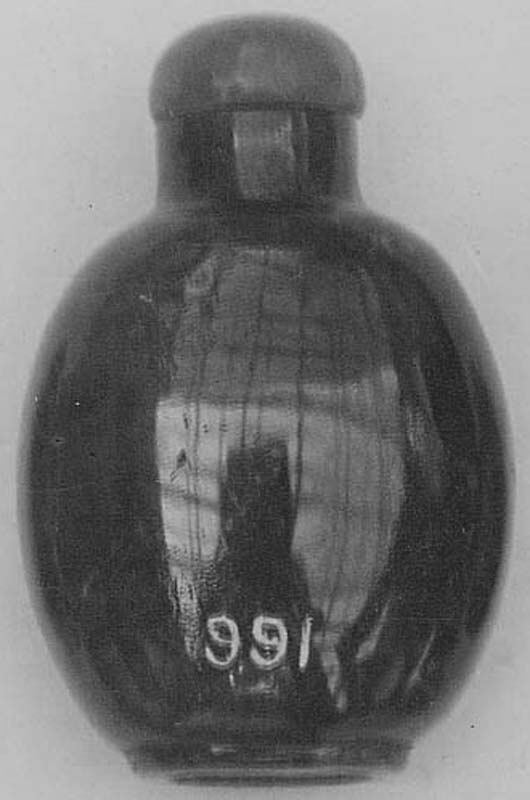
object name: snuff bottle with stopper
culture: chinese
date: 1701-1900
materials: stone, quartz